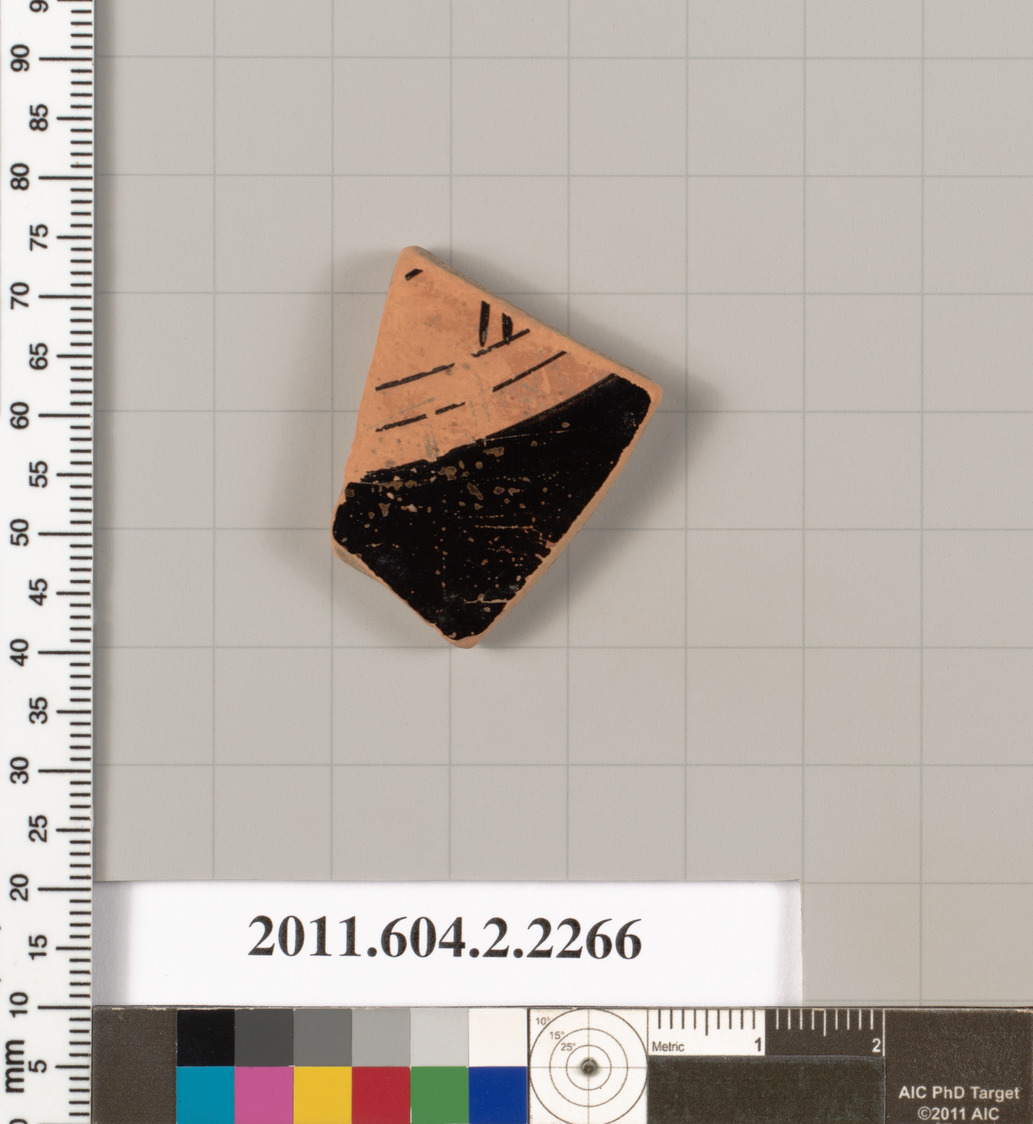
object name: krater fragment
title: Terracotta fragment of a krater (bowl for mixing wine and water)?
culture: greek, attic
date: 475-451 BCE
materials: terracotta